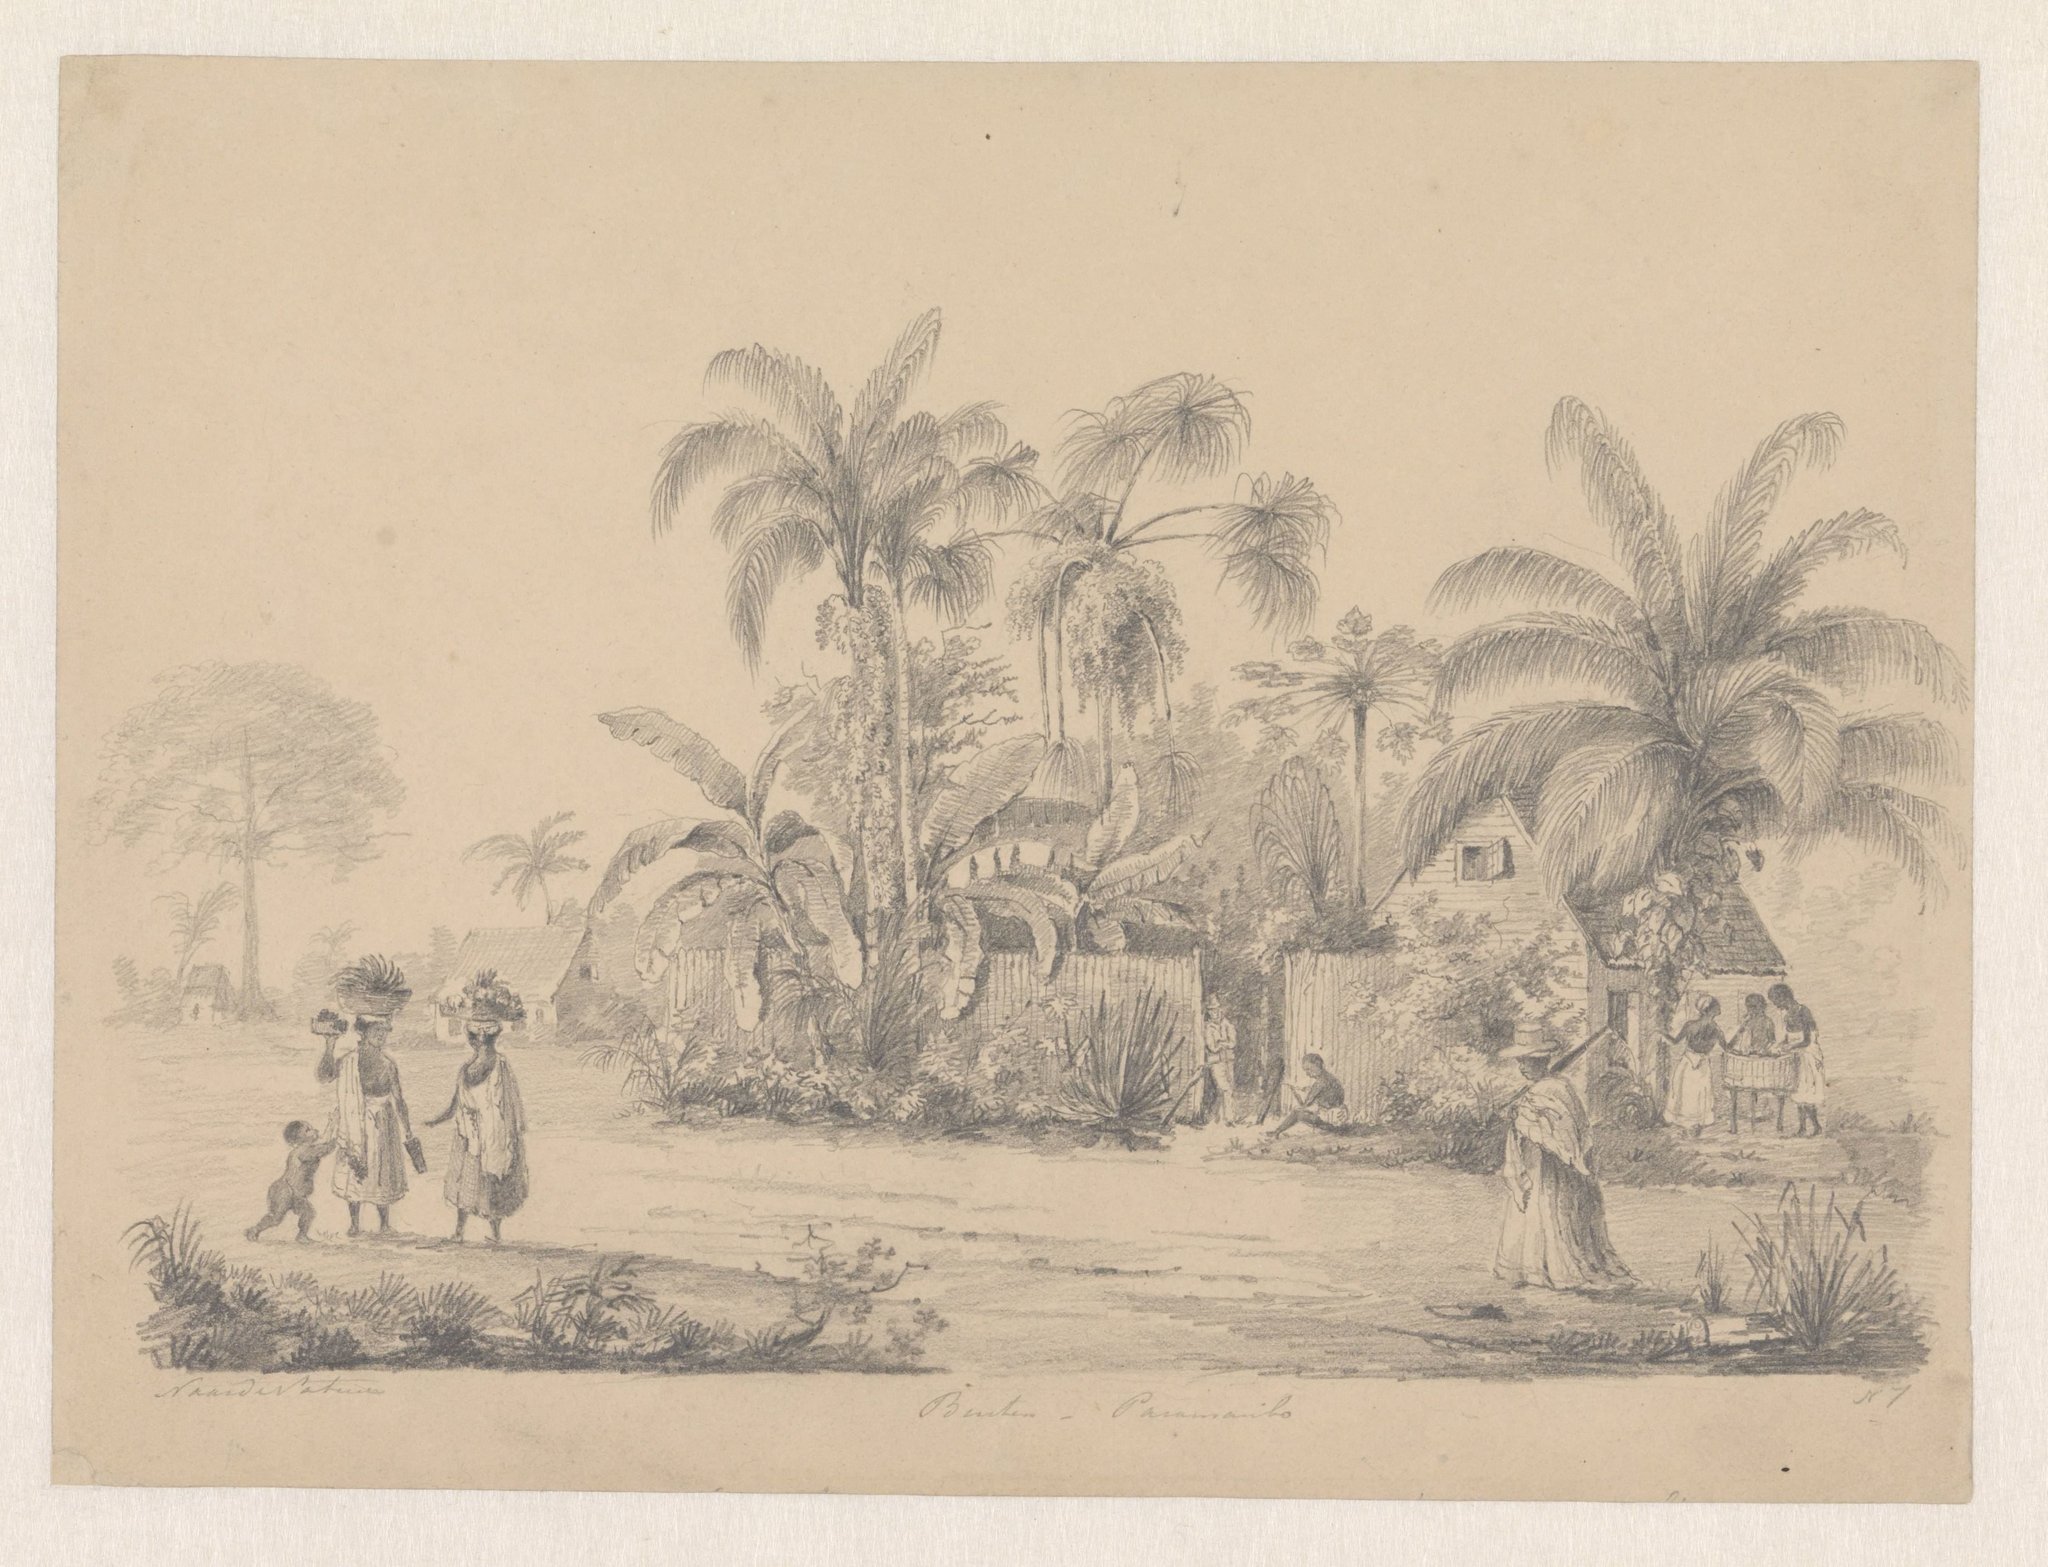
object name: drawing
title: Straatgezicht net buiten Paramaribo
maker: hendrik huygens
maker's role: amateurtekenaar, officier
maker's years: 1810-1867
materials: paper, pencil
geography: paramaribo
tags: landscapes in tropical and sub-tropical regions, suriname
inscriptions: inscription: ‘Naar de Natuur / Buiten-Paramaribo / N 1 (of 7)’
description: Een straatgezicht net buiten Paramaribo met links twee vrouwen met manden met bananen op hun hoofd, vergezeld door een kind. Rechts loopt een vrouw met omslagdoek en hoed en een parasol over de schouder. Aan de straat staat een eenvoudig huis met een grote houten schutting er omheen. Bij het huis staan drie mensen bij een grote wastobbe.